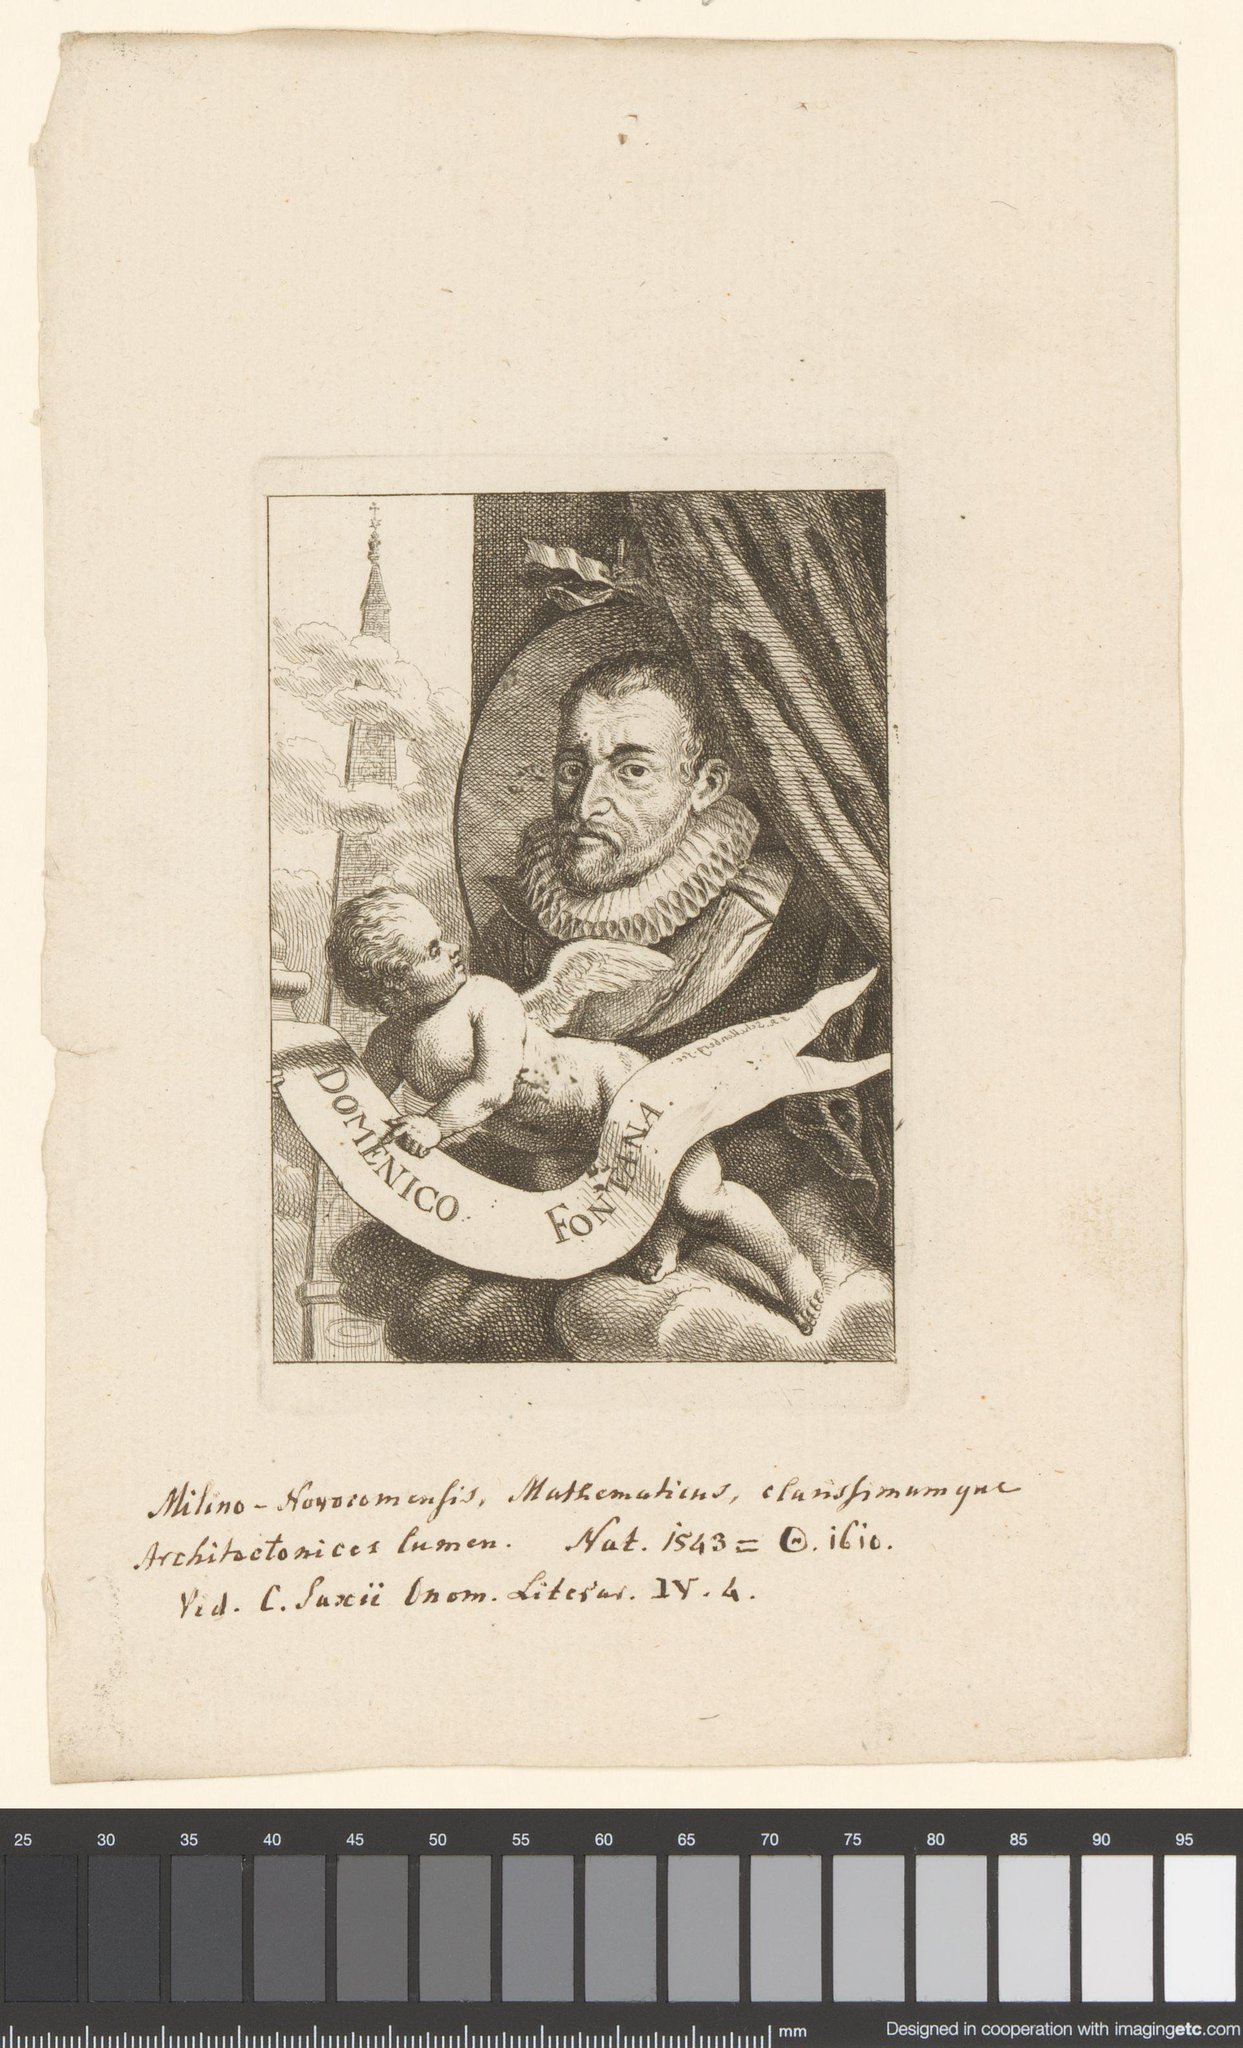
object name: print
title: Portret van Domenico Fontana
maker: johann rudolph schellenberg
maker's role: print maker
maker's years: 1740-1806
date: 1750-1806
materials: paper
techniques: etching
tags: naples, domenico fontana, obelisk, needle, portrait, self-portrait of architect, cupids: 'amores', 'amoretti', 'putti'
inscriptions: collector's mark: Lugt 2228